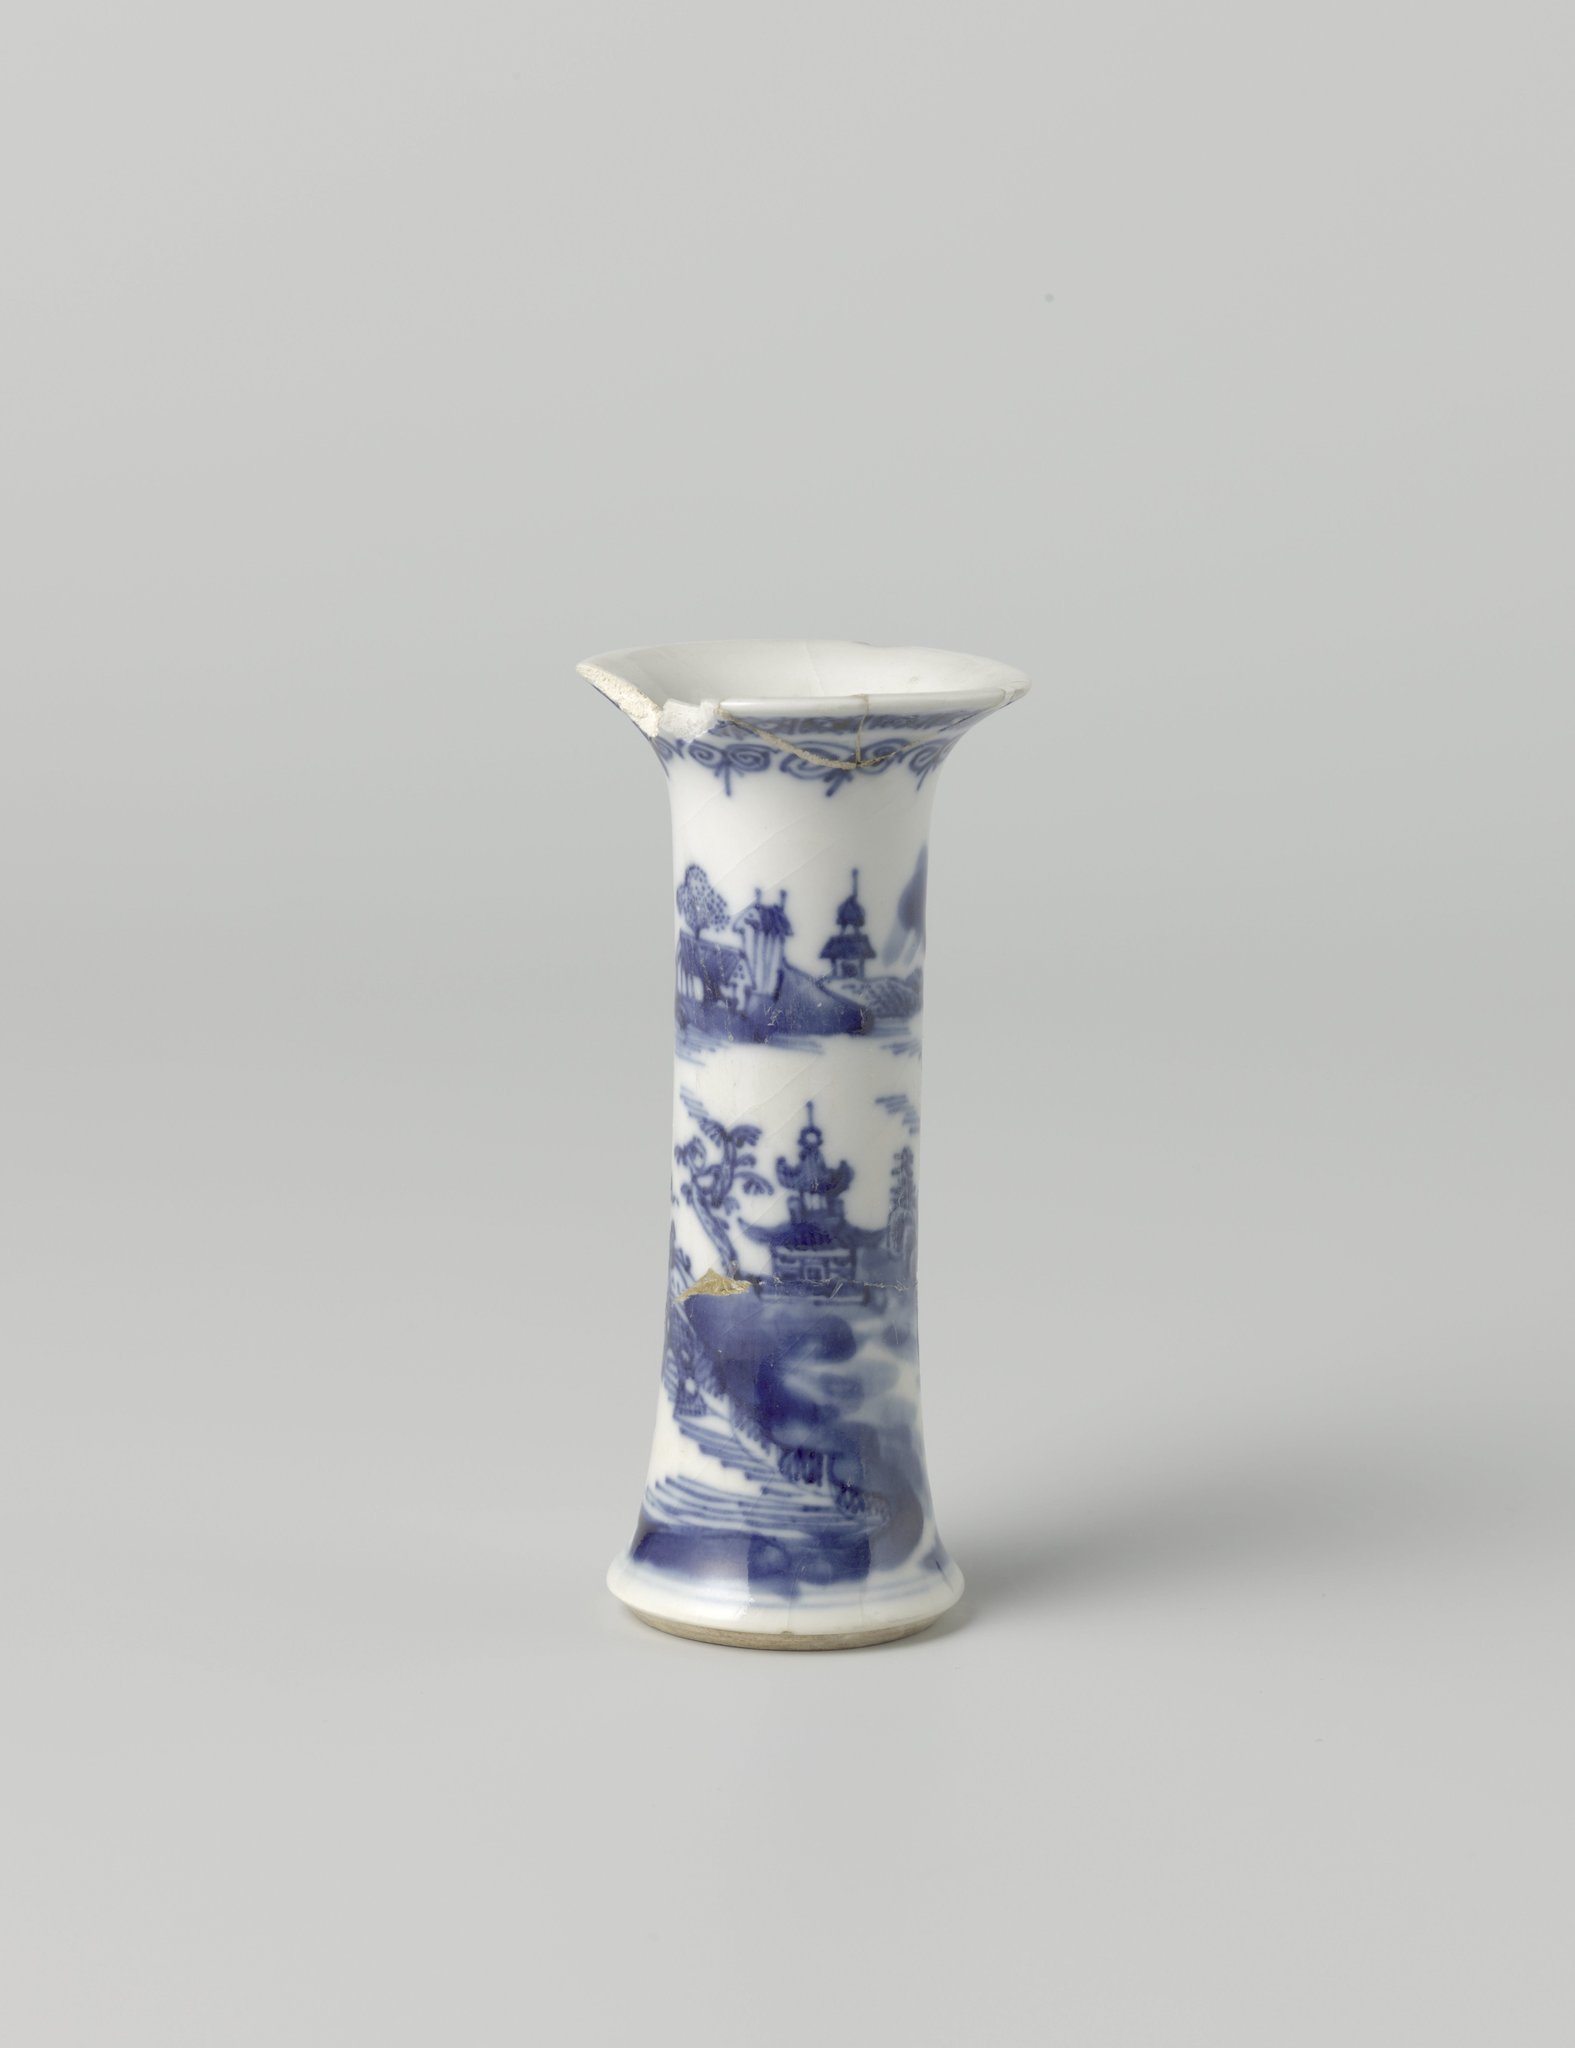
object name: bekervaas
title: Miniature trumpet-shaped beaker vase with river landscape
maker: Anonymous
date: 1800-1899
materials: cobalt, glaze, paint, porcelain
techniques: firing, turning, vitrification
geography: china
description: Miniatuur trompetvormige bekervaas van porselein, beschilderd in onderglazuur blauw. Op de wand een rivierlandschap met rotsen, bomen en paviljoens; om de rand twee decoratieve banden. De vaas is gebroken geweest, deel missend uit de rand. Blauw-wit.